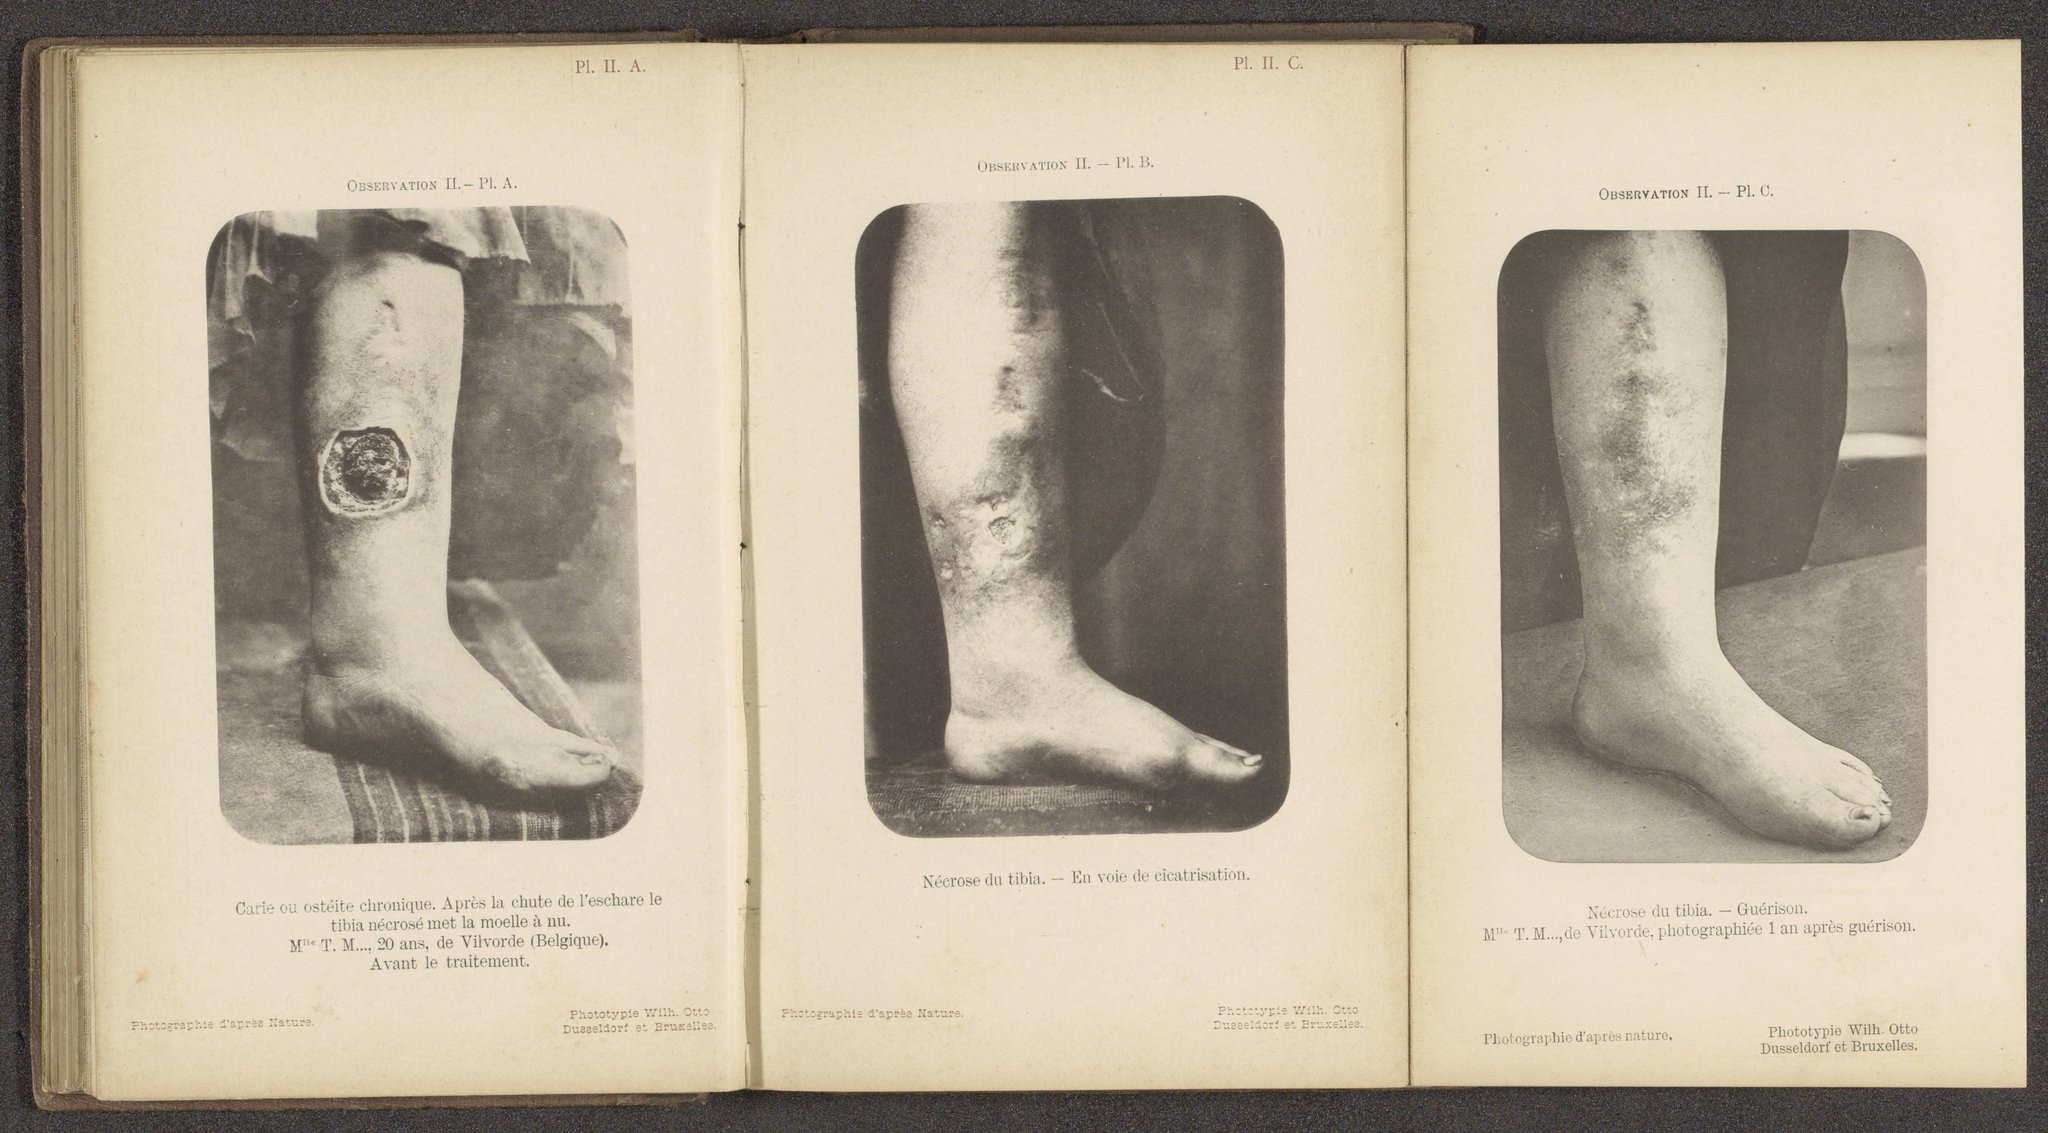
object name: page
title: Scheenbeen met een helende necrotische wond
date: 1874-1884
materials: paper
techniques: photograph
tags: infections and wounds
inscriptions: inscription: ‘Pl. II. C. / Observation II. - Pl. B. / Nécrose du tibia. - En voie de cicatrisation.’